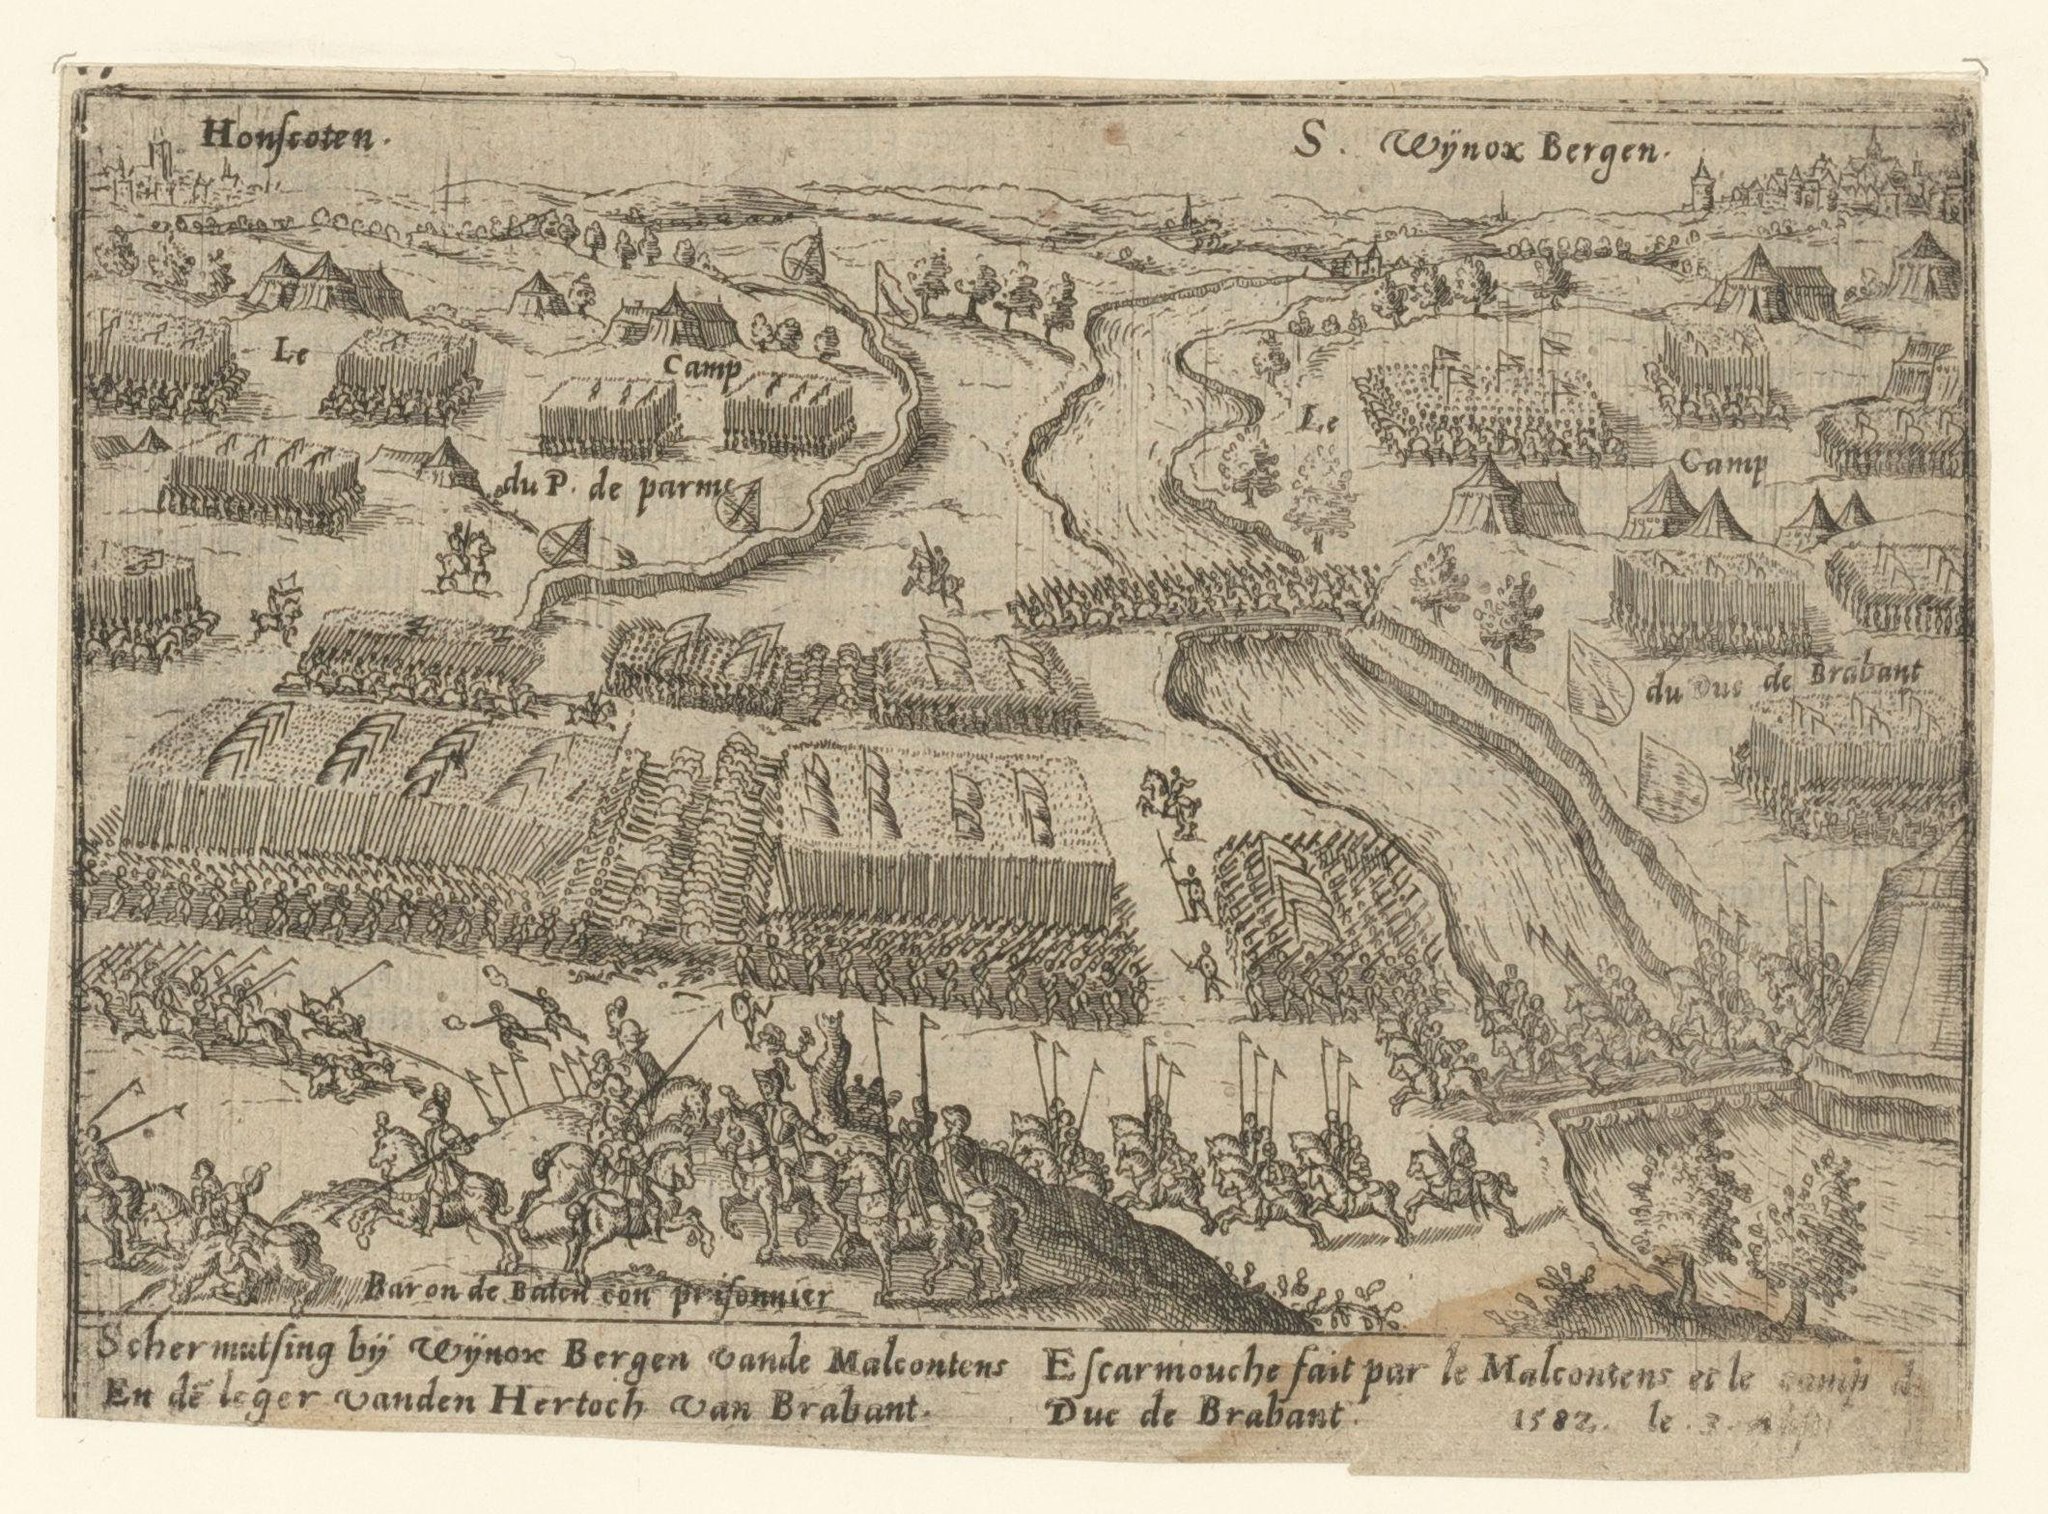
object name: history print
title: Schermutseling bij Sint-Winoksbergen, 1582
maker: Anonymous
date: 1613-1615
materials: paper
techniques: etching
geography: northern netherlands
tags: paris, françois-hercule de valois (hertog van anjou), rome, alessandro farnese (landvoogd van de nederlanden en hertog van parma en piacenza), battle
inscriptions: collector's mark, collector's mark: Lugt 1641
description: Schermutselingen tussen de legers van de hertog van Parma en de hertog van Anjou bij Sint-Winoksbergen (Wijnoxbergen), 3 augustus 1582. Met onderschrift van 2 regels in het Nederlands en 2 regels in het Frans. Ongenummerd. Bedrukt op achterzijde met tekst in het Nederlands. Onderwerpsrubrieken binnen de Atlas Zeden en Gewoonten: Krijgswezen; prenten van Baudart. 80j. oorlog.